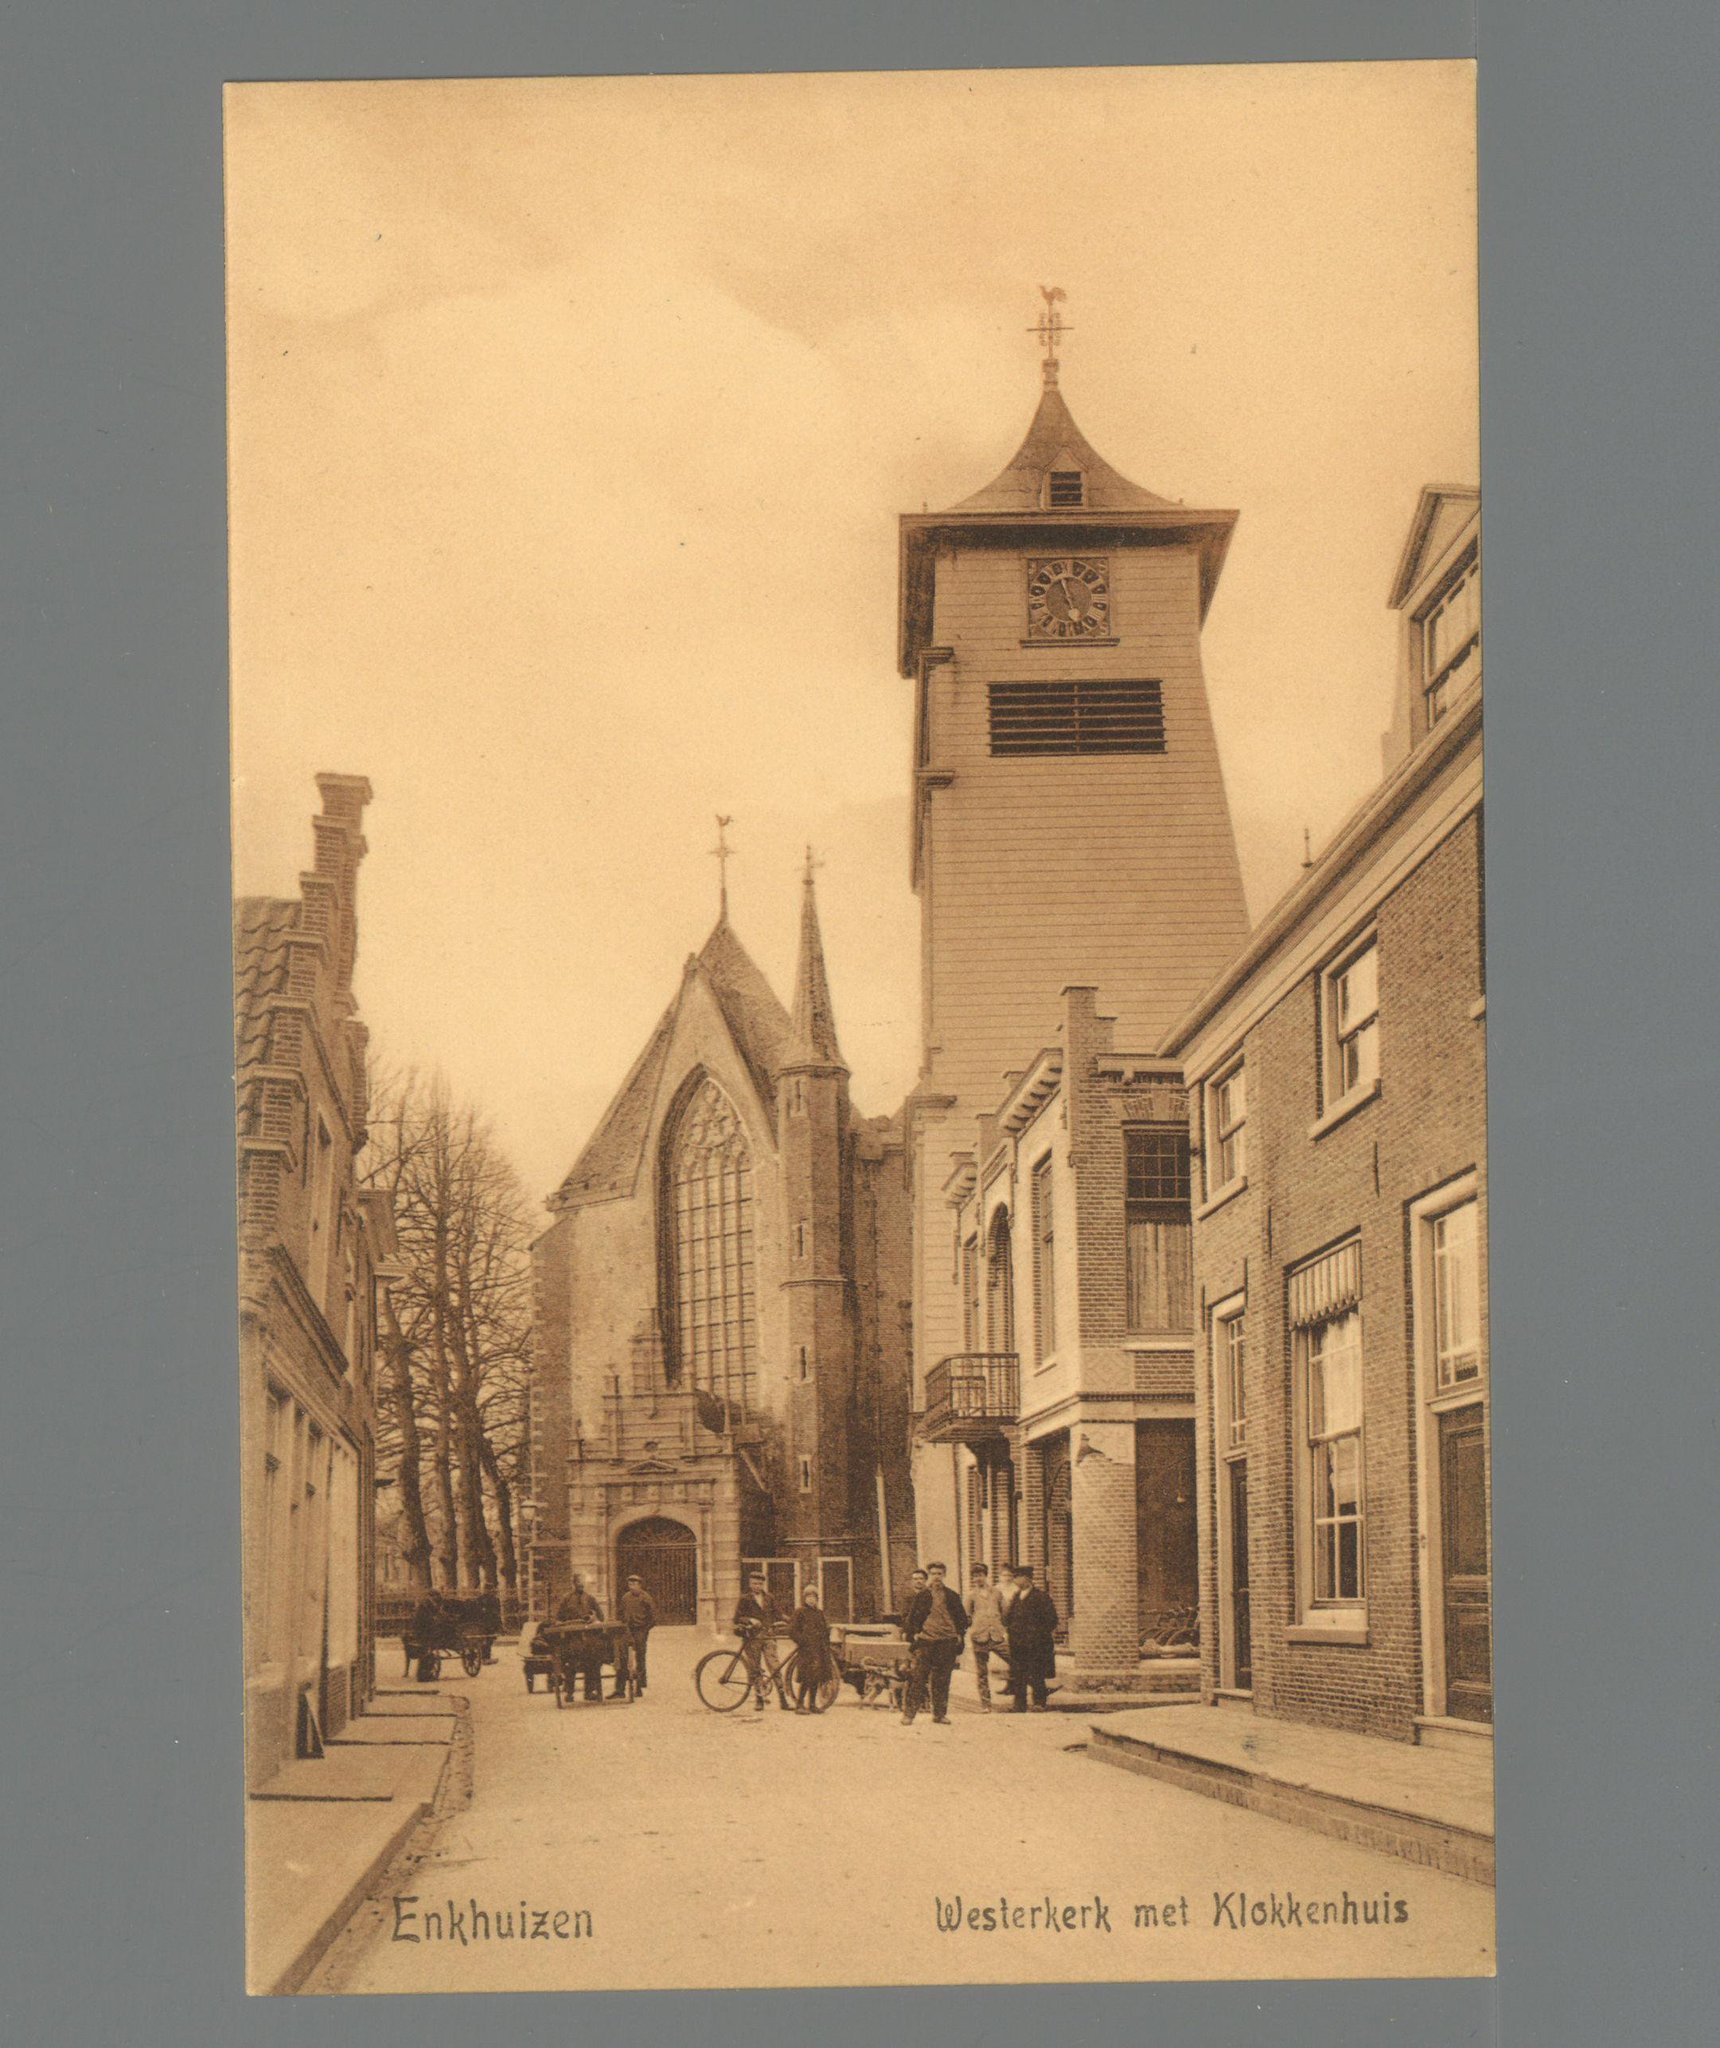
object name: ansichtkaart, prentbriefkaart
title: Enkhuizen. Westerkerk met klokkenhuis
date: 1906-1919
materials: cardboard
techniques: photograph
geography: enkhuizen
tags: parts of church exterior and annexes: campanile, city-view, and landscape with man-made constructions, church (exterior), street, enkhuizen